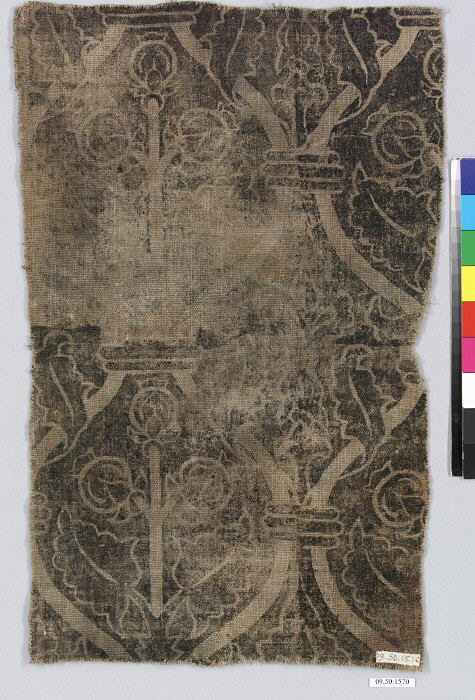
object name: fragment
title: Fragment of reproduction of 16th century design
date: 1801-1900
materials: linen